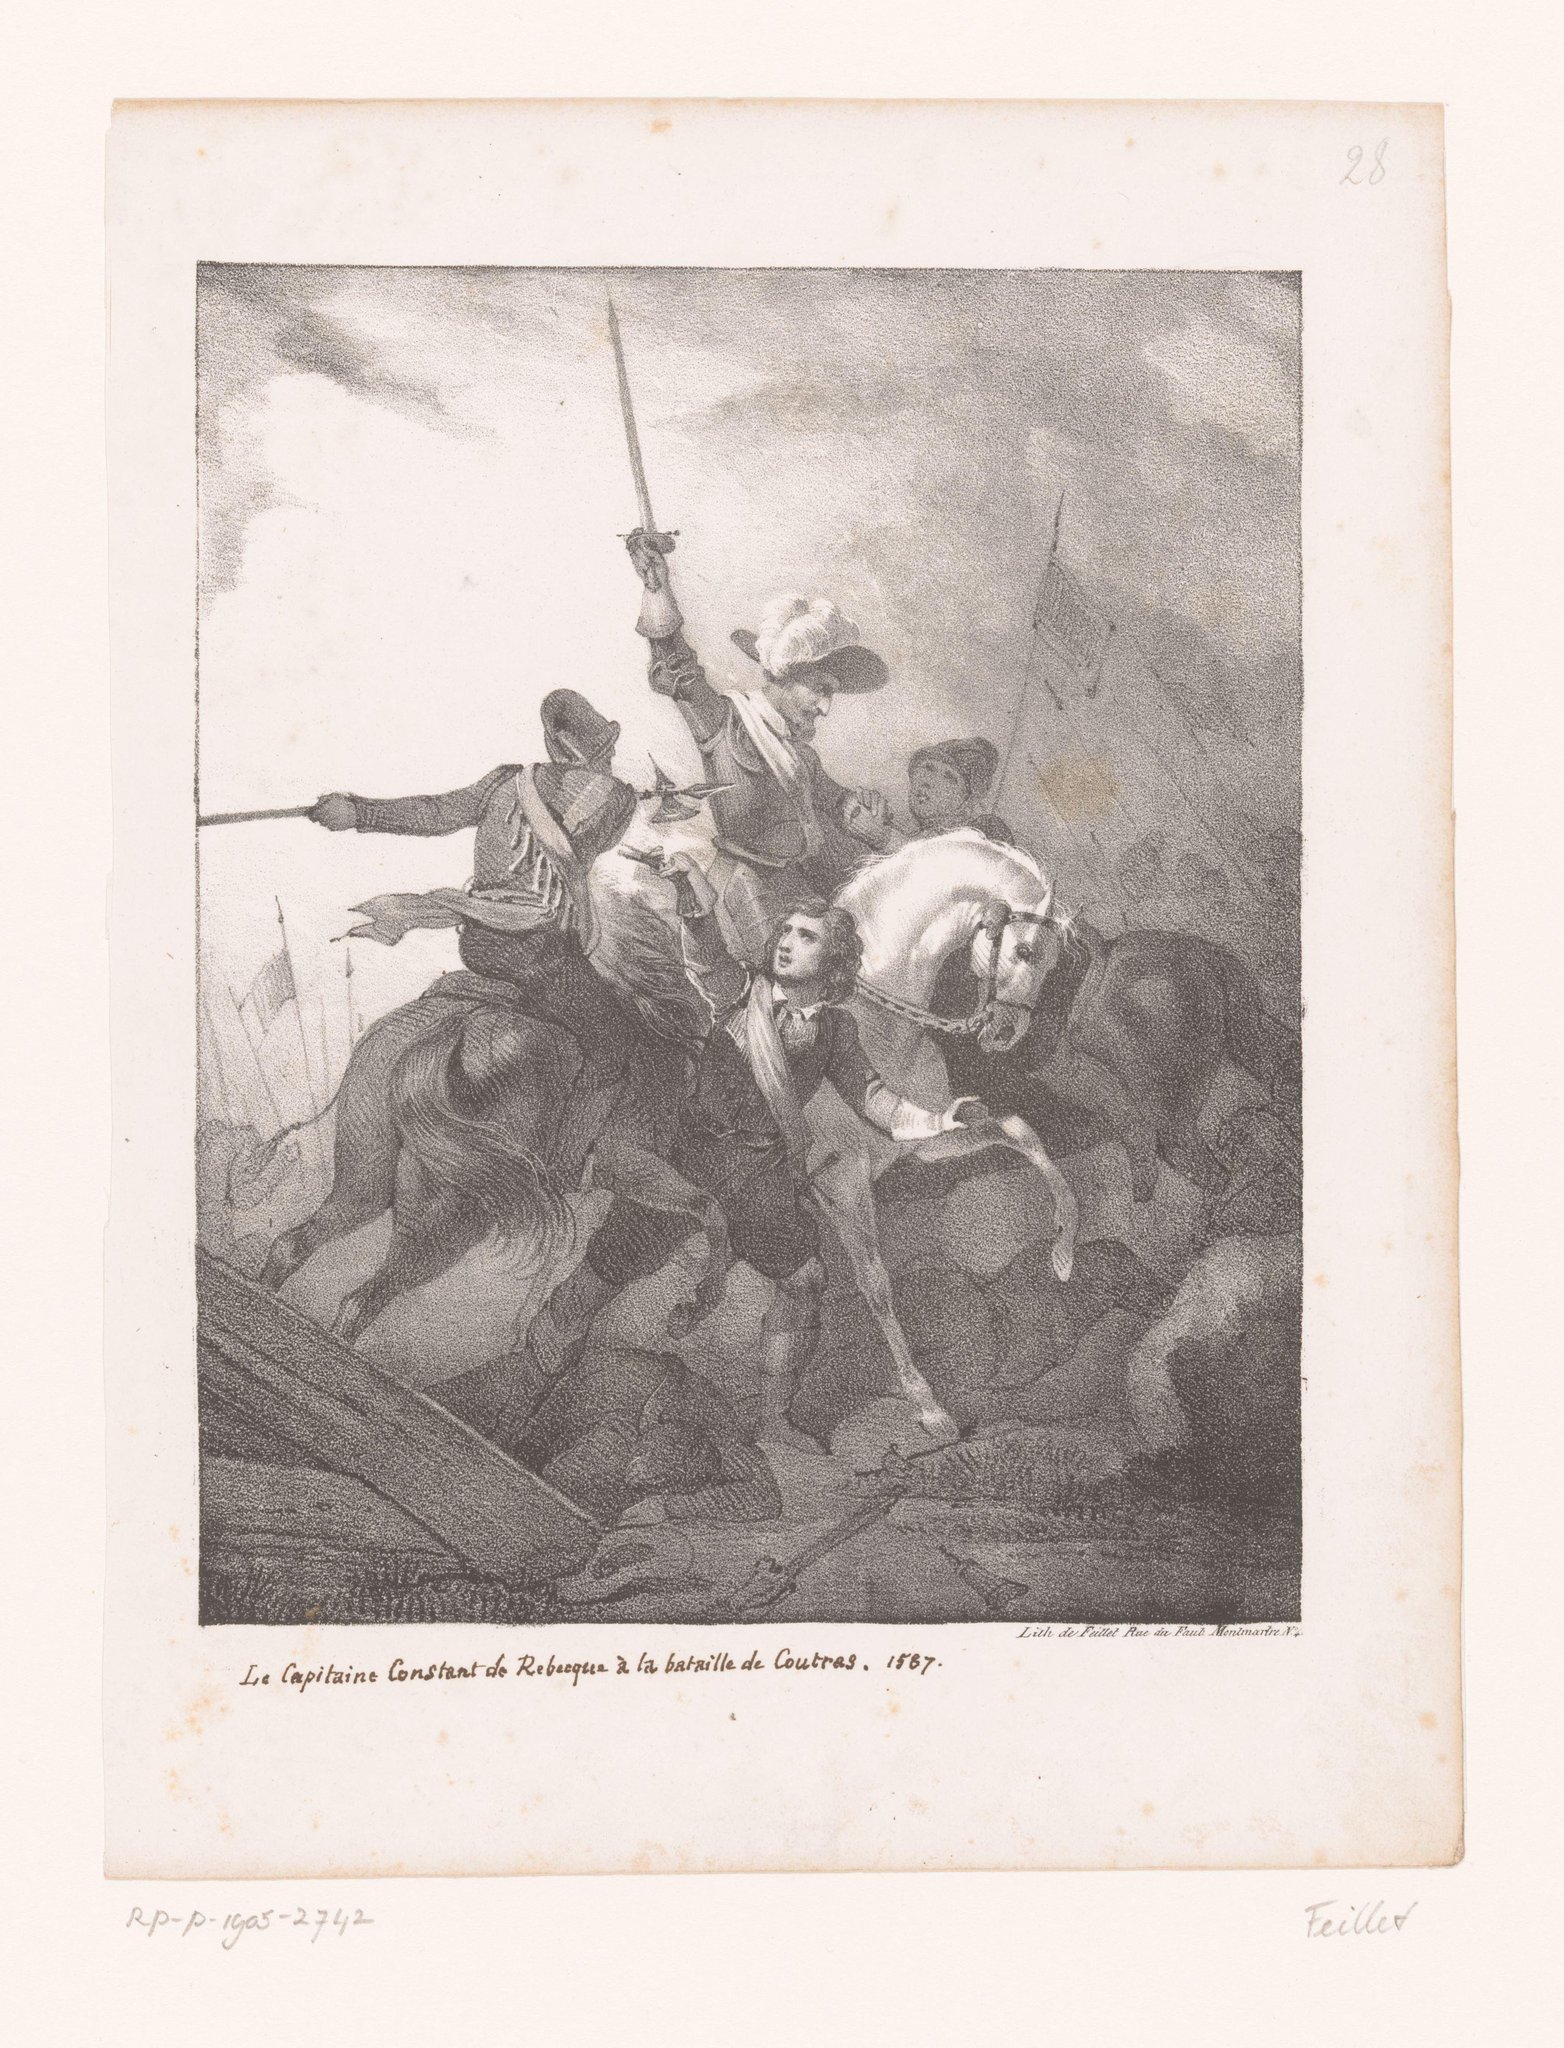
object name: print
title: Kapitein Constant de Rebecque tijdens de slag bij Coutras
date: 1823-1828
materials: paper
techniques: lithograph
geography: paris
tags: battle (+ cavalry, horsemen)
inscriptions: collector's mark: Lugt 2228a